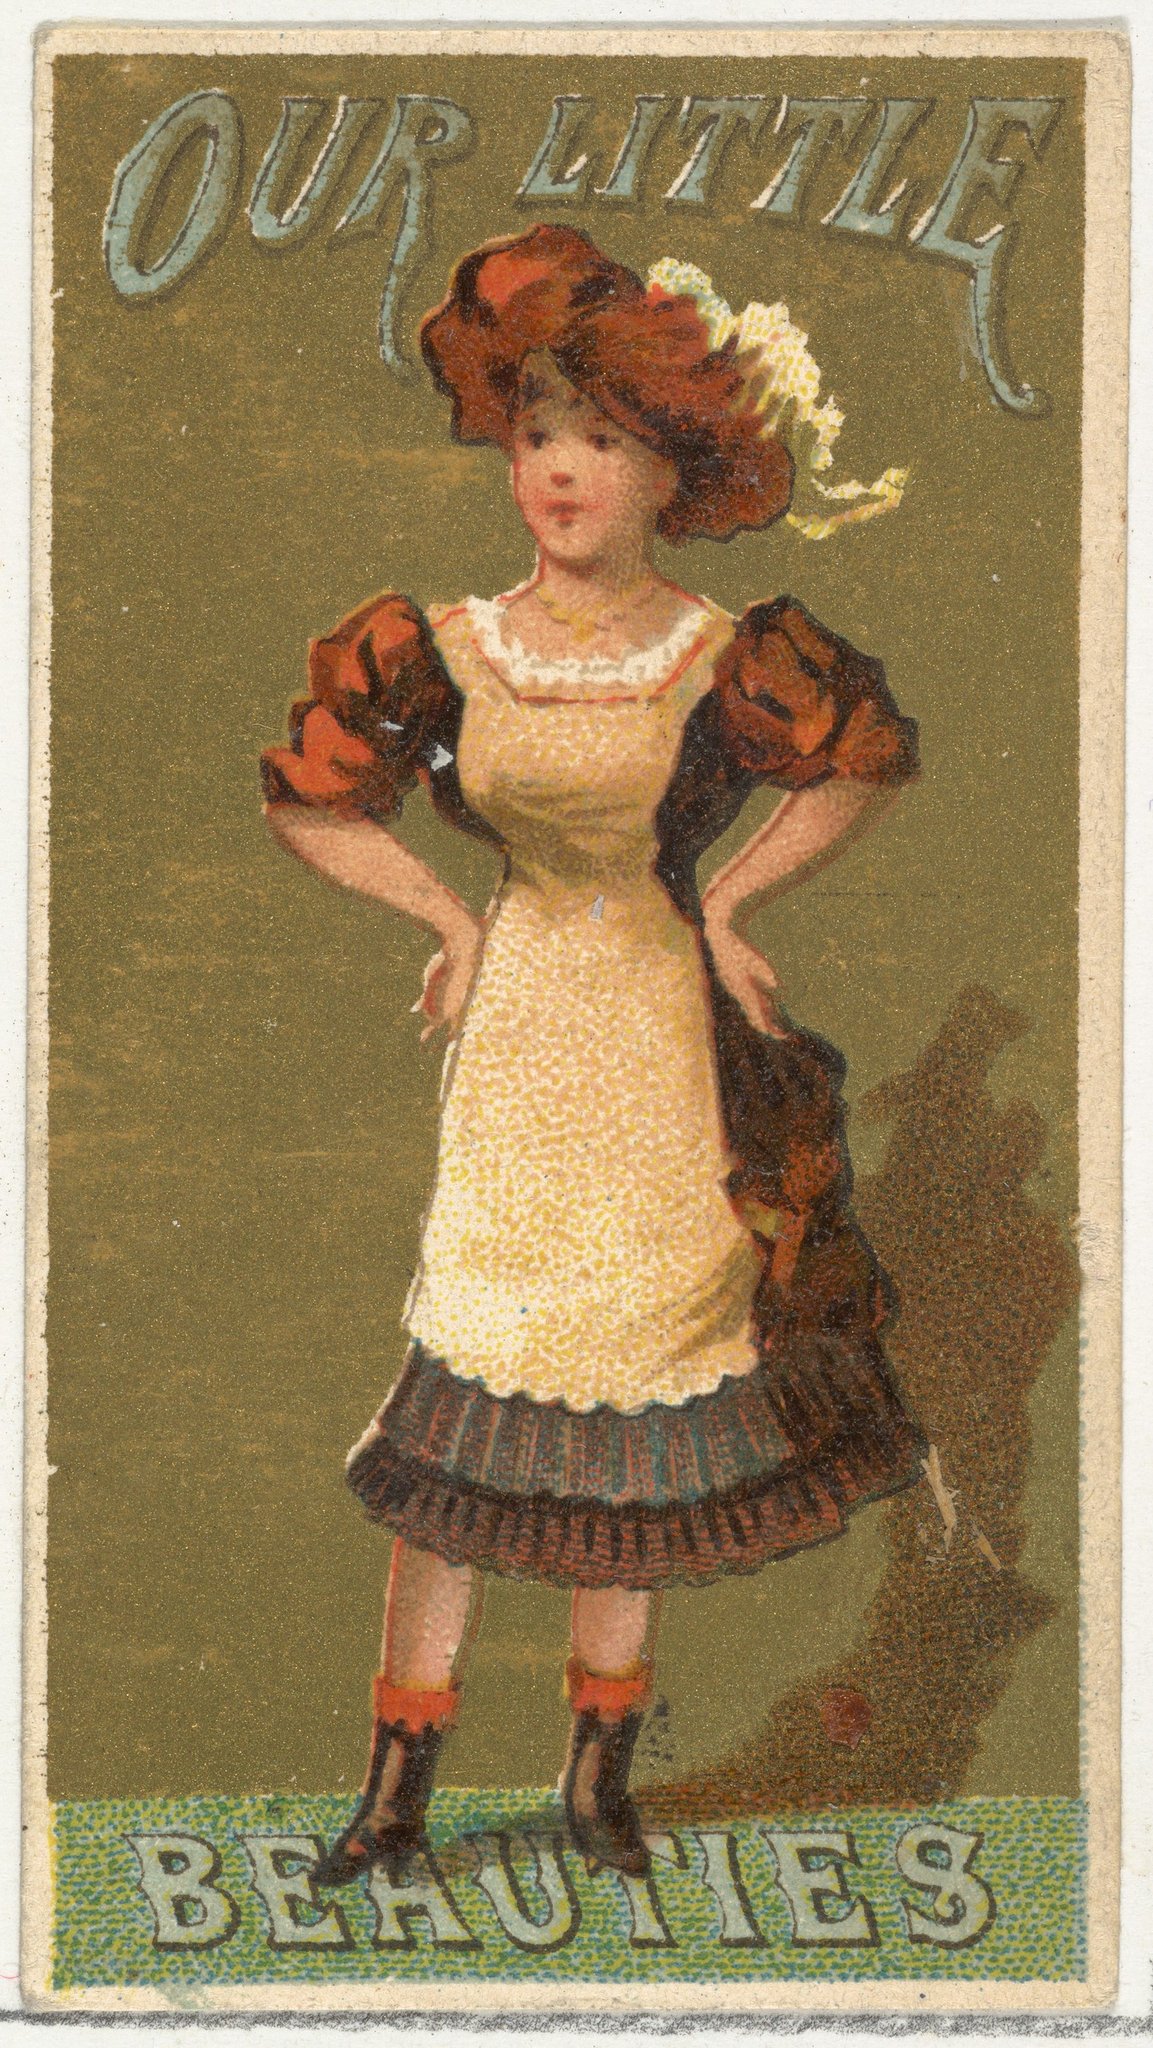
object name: print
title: From the Girls and Children series (N58) promoting Our Little Beauties Cigarettes for Allen & Ginter brand tobacco products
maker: allen & ginter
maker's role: publisher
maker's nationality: american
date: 1887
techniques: color lithograph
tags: girls